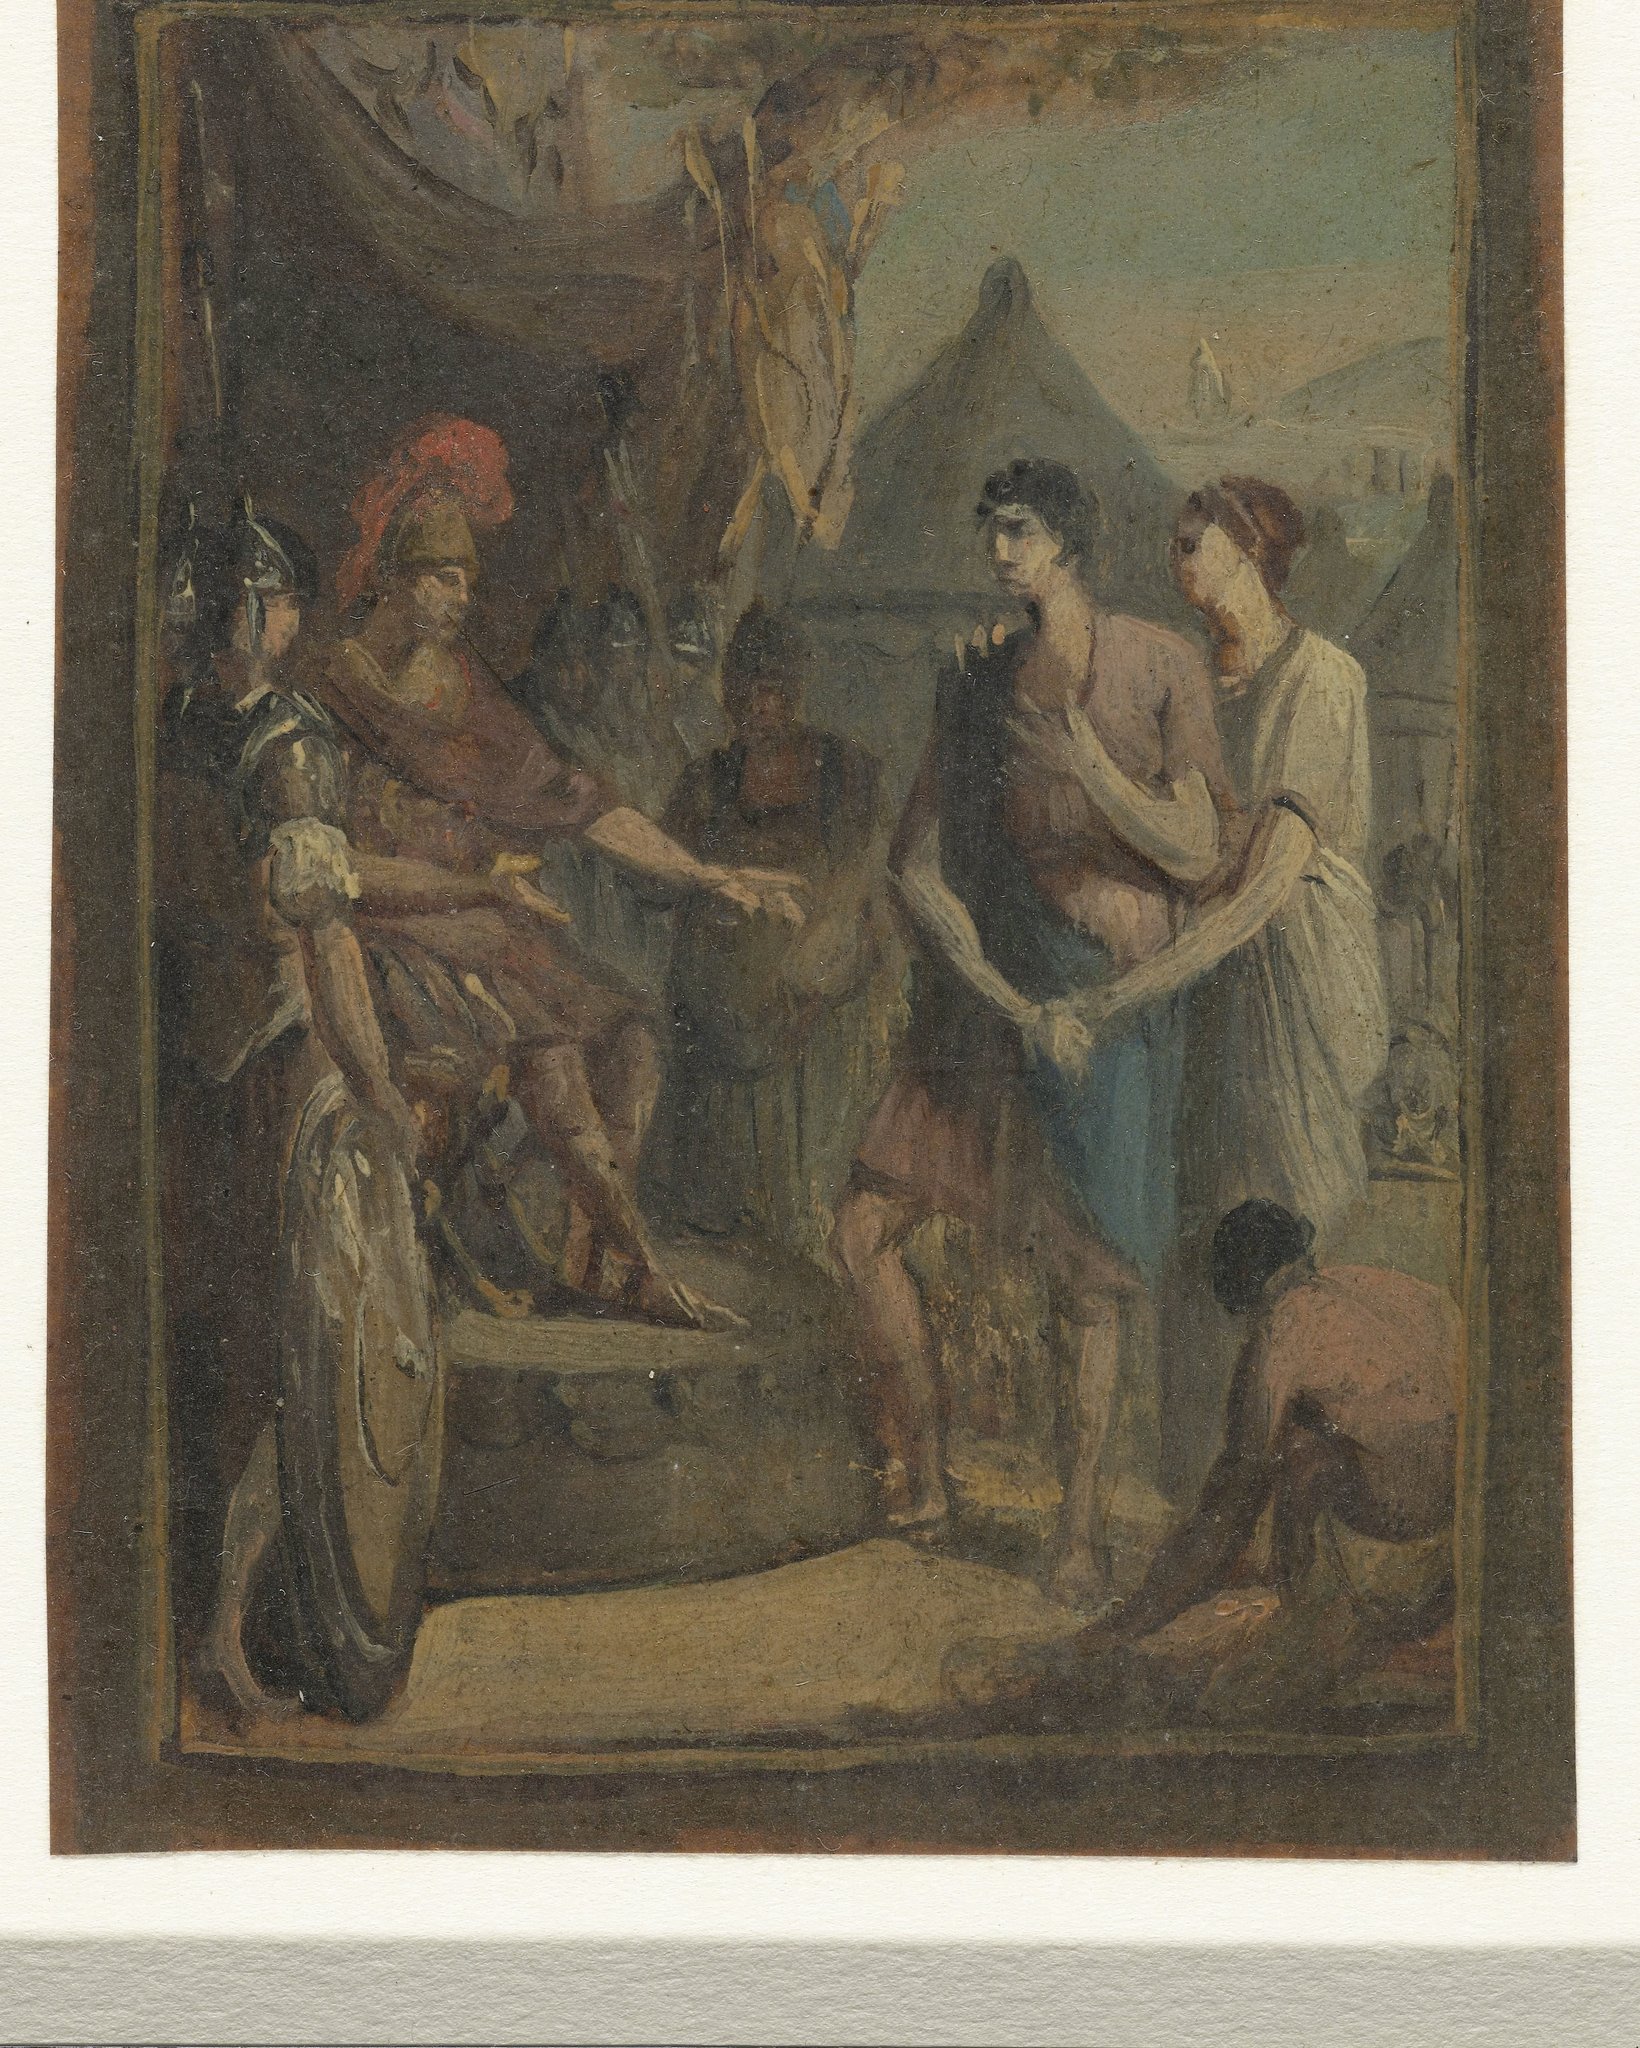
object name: drawing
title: Twee jongelingen voorgesteld aan een veldheer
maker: Anonymous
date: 1700-1800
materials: oil, paper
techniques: brush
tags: officer